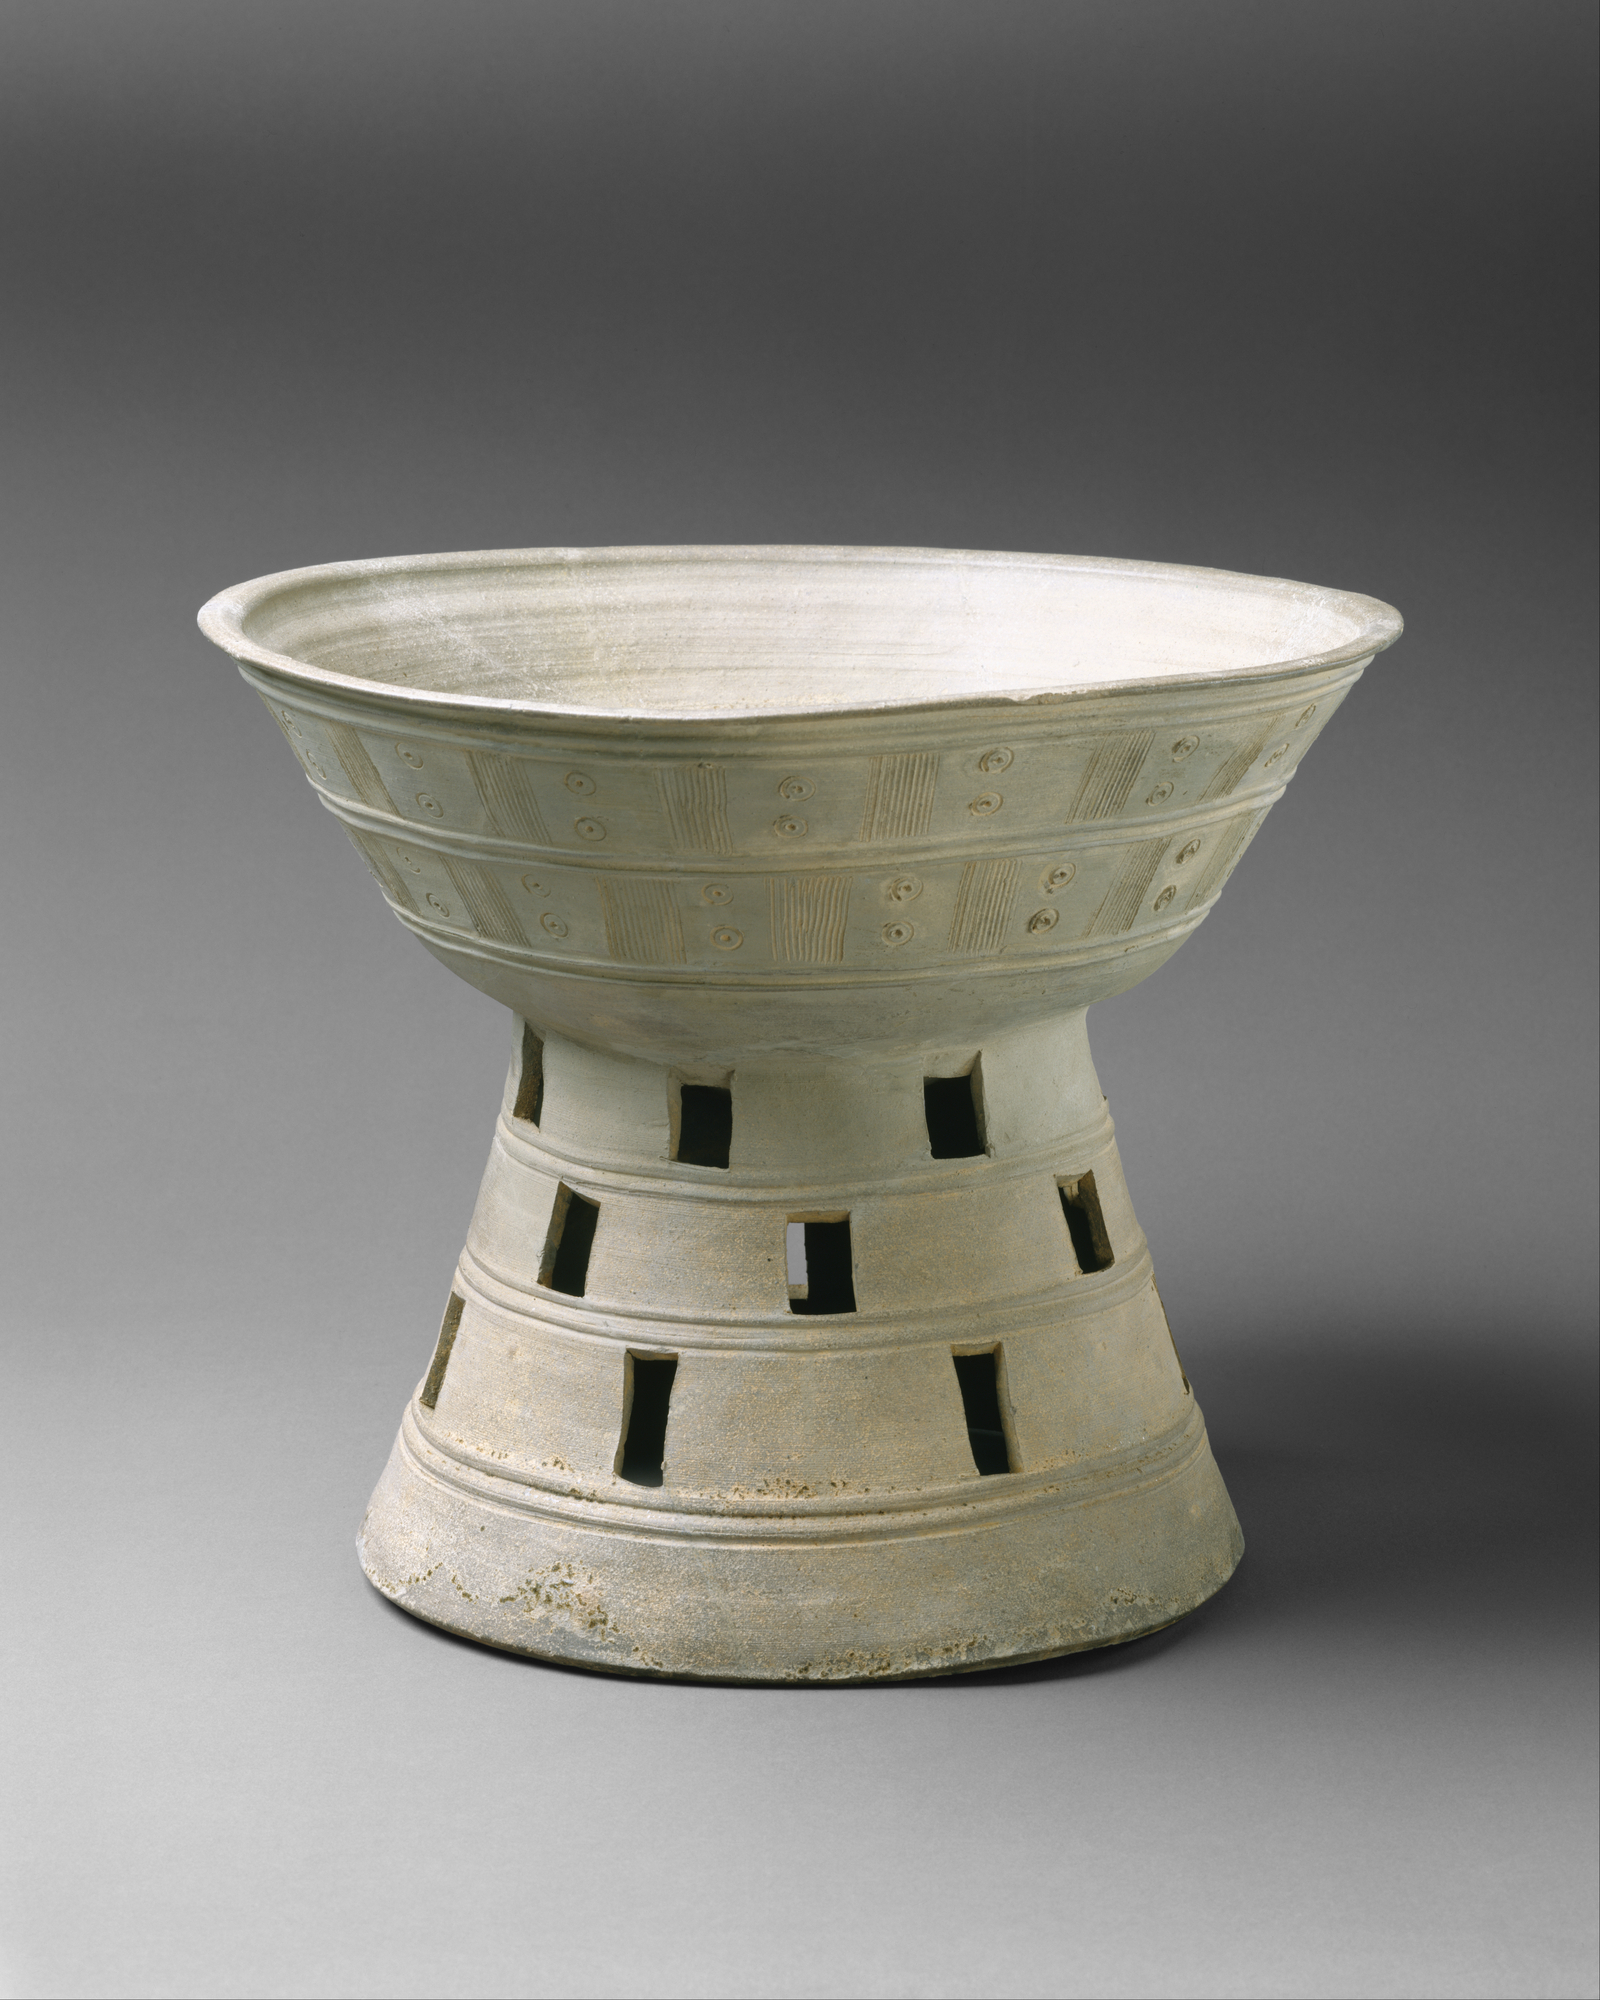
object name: stand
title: Stand with perforated base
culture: korean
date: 401-600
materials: wood, glaze, stoneware